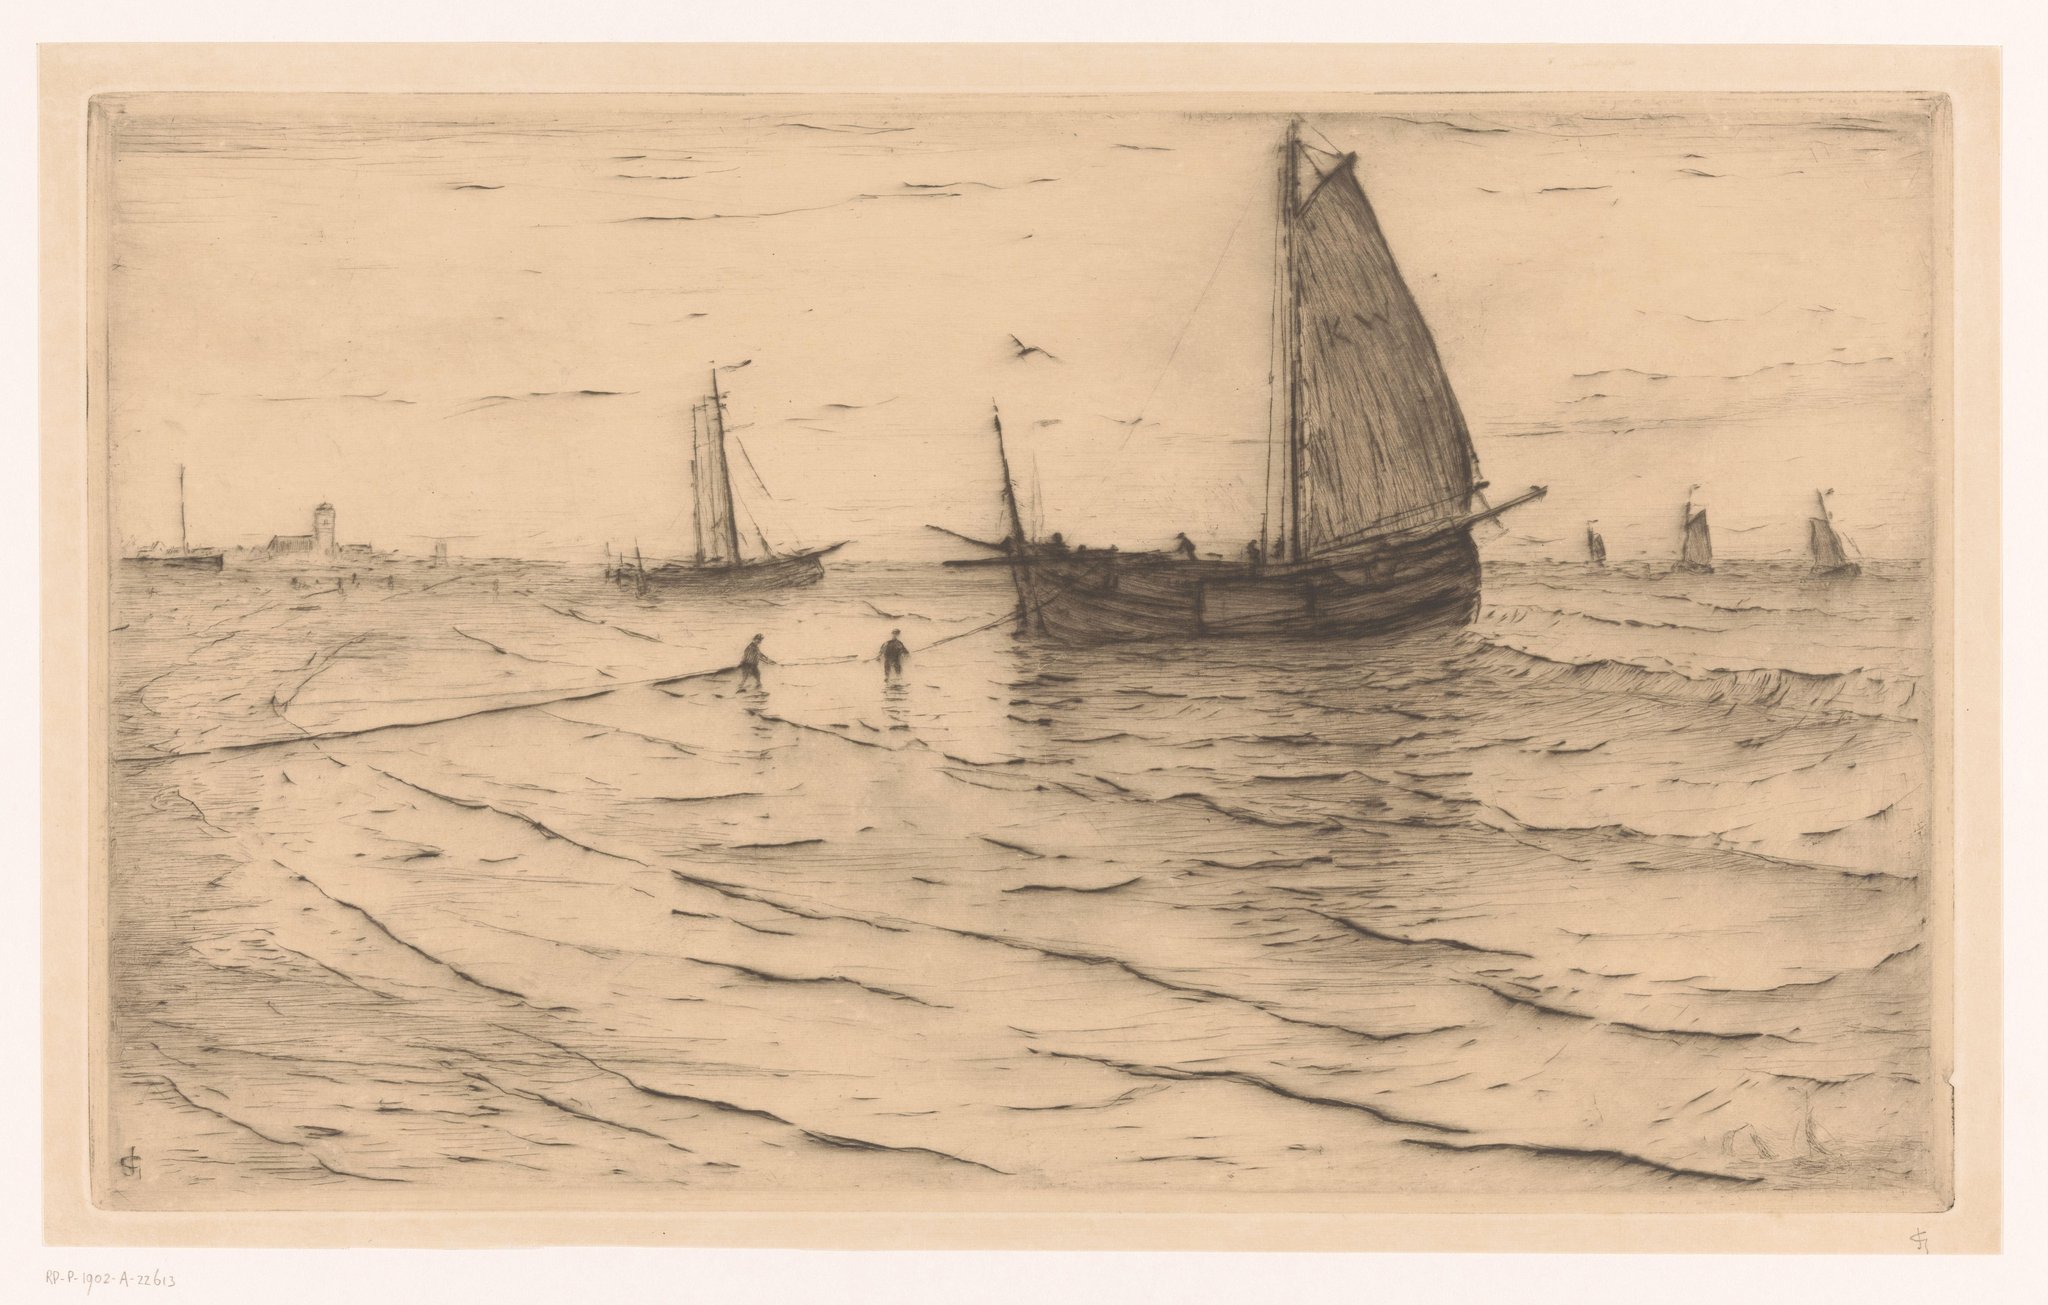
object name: print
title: Vloed bij Katwijk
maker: carel nicolaas storm van s-gravesande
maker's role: draughtsman, print maker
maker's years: 1841-1924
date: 1887-1889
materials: paper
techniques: drypoint, etching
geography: netherlands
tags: prospect of village, silhouette of village, sailing-ship, sailing-boat, beach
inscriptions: number: ‘256’, collector's mark: Lugt 2228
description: Mogelijk ook vermeld in: Storm van 's-Gravesande, Charles. Catalogue des eaux-fortes et lithographies. New York: s.n., 1903, of in een onbekende latere uitgave van het manuscript. Vermoedelijk vermeld als catalogusnummer 256.